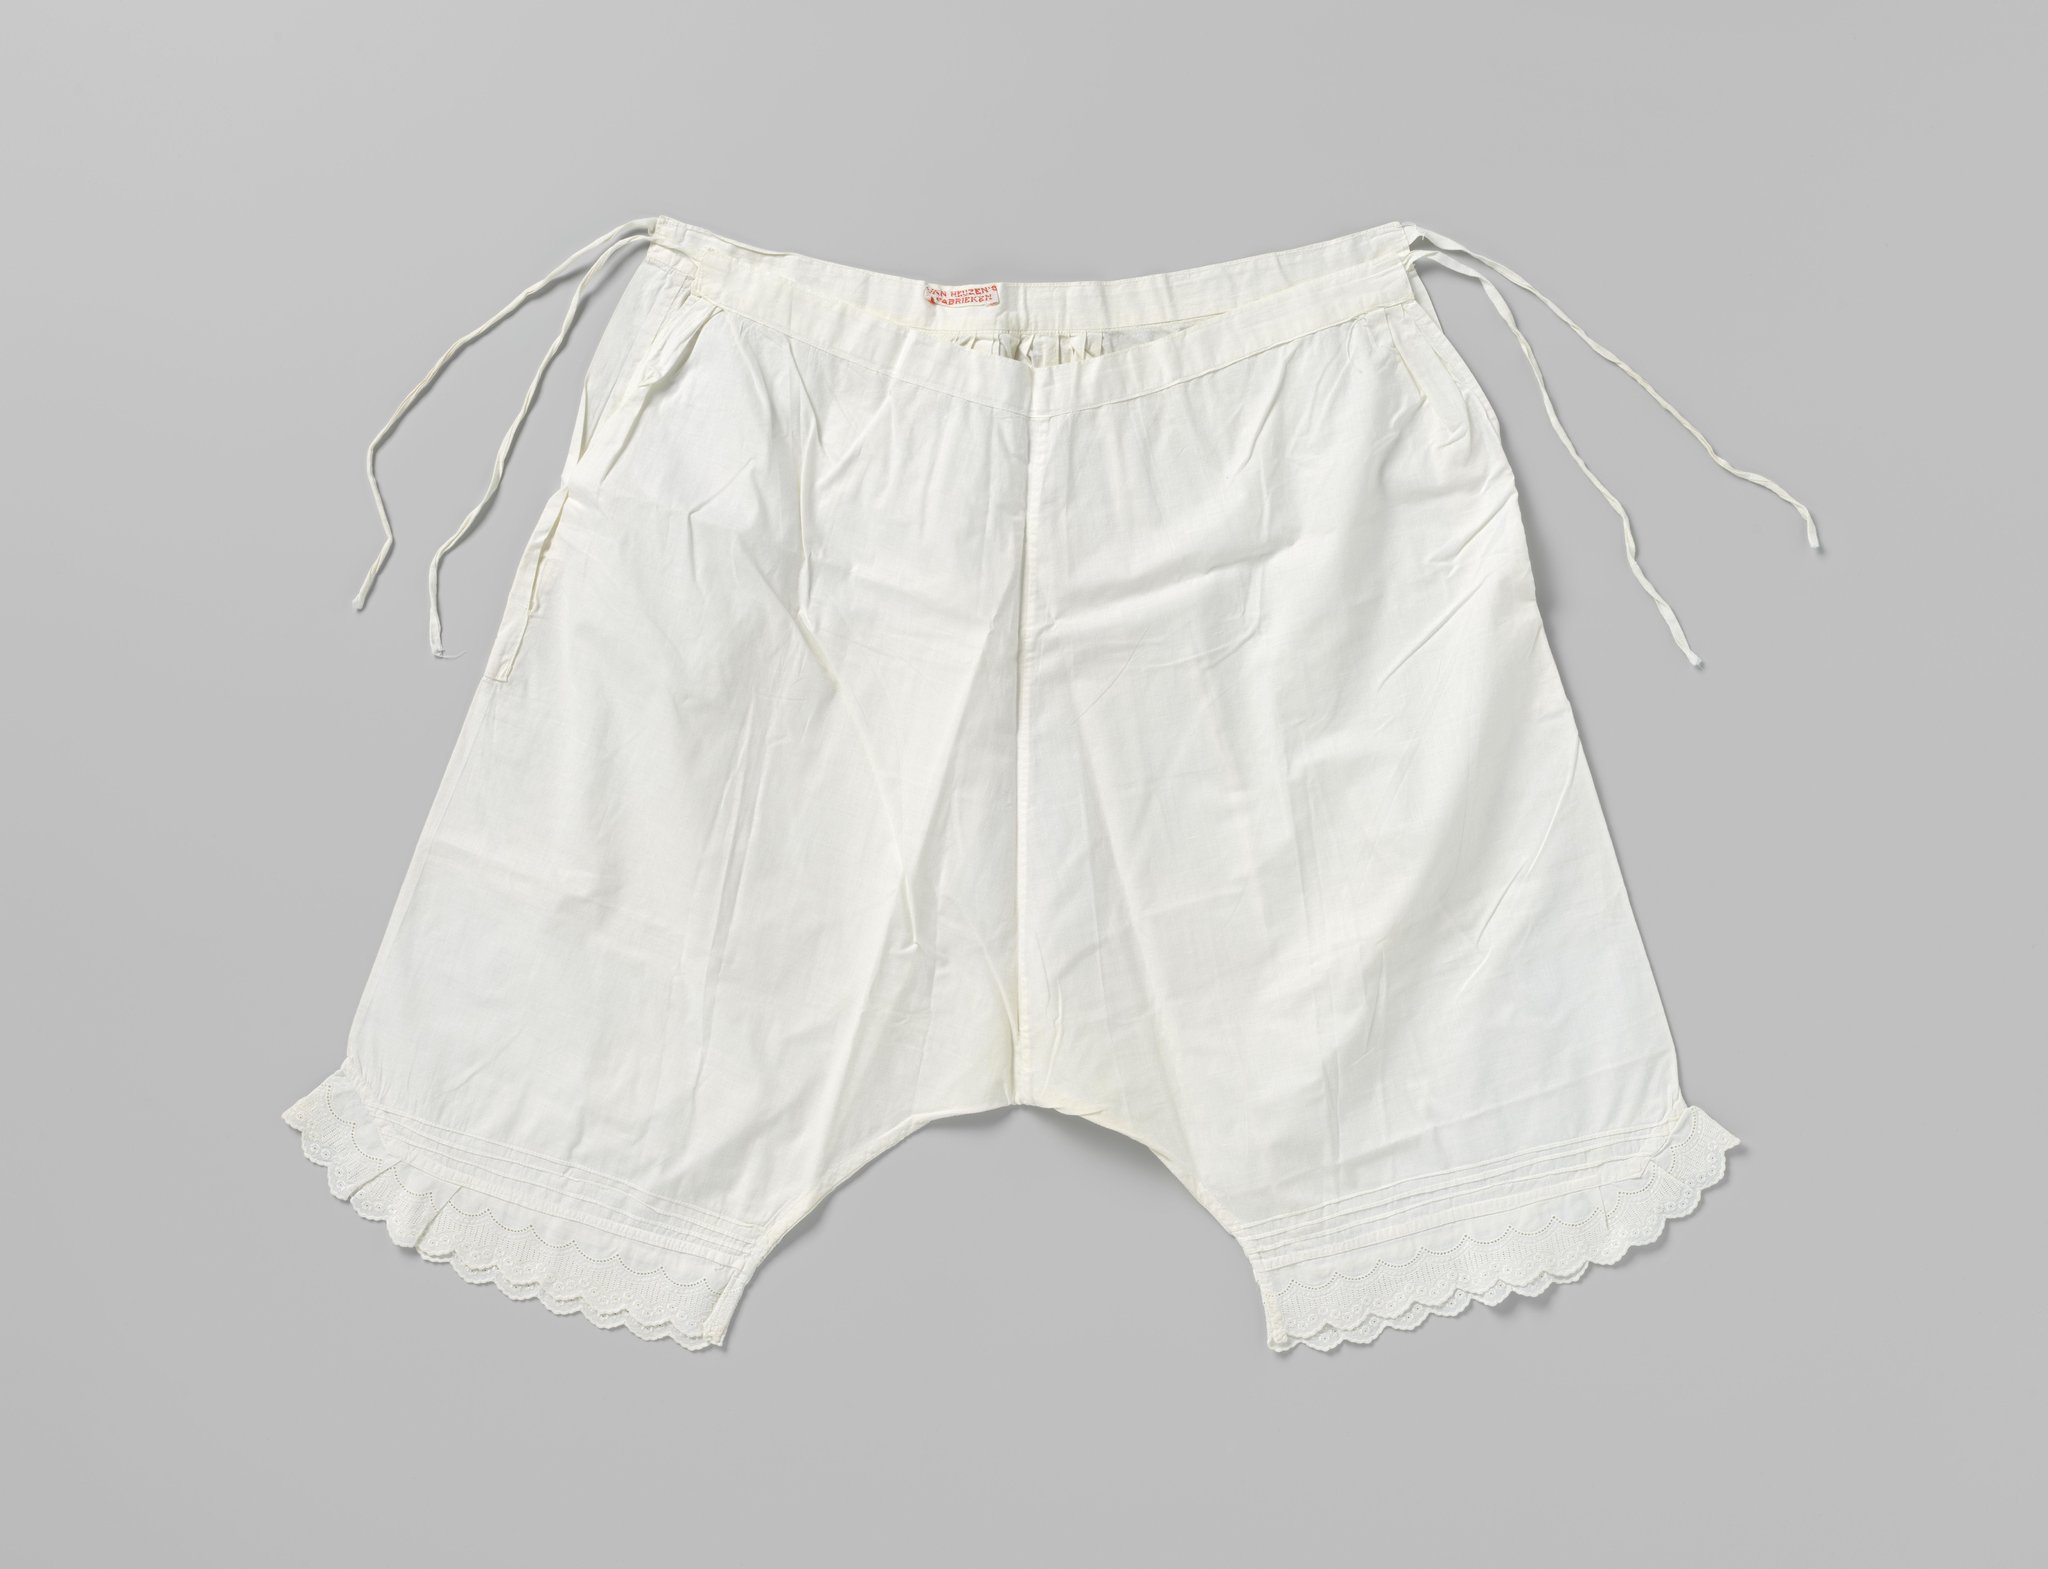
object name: womenswear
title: Damesonderbroek van katoen en broderie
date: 1900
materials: cotton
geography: netherlands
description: Damesonderbroek van katoen en broderie. Met bandjes te sluiten klepmodel met brede tailleband. Korte pijpen, afgezet met geschulpte rand met Engels borduurwerk. In tailleband een etiket: VAN HEUZEN's FABRIEKEN.